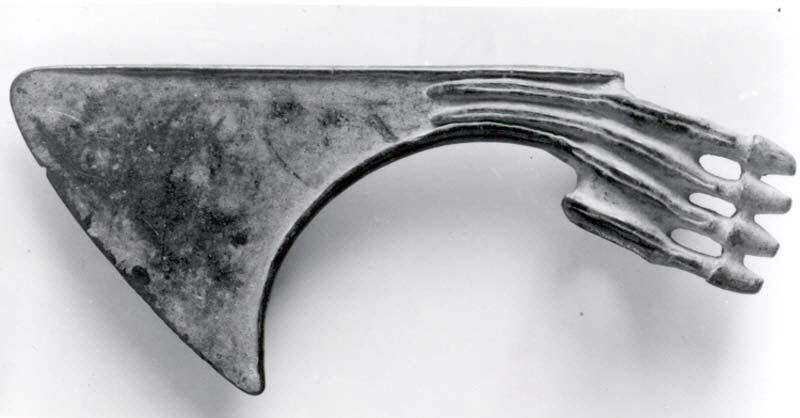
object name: axe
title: Spiked axe head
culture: iranian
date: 1200-900 BCE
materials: bronze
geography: iran, probably from luristan